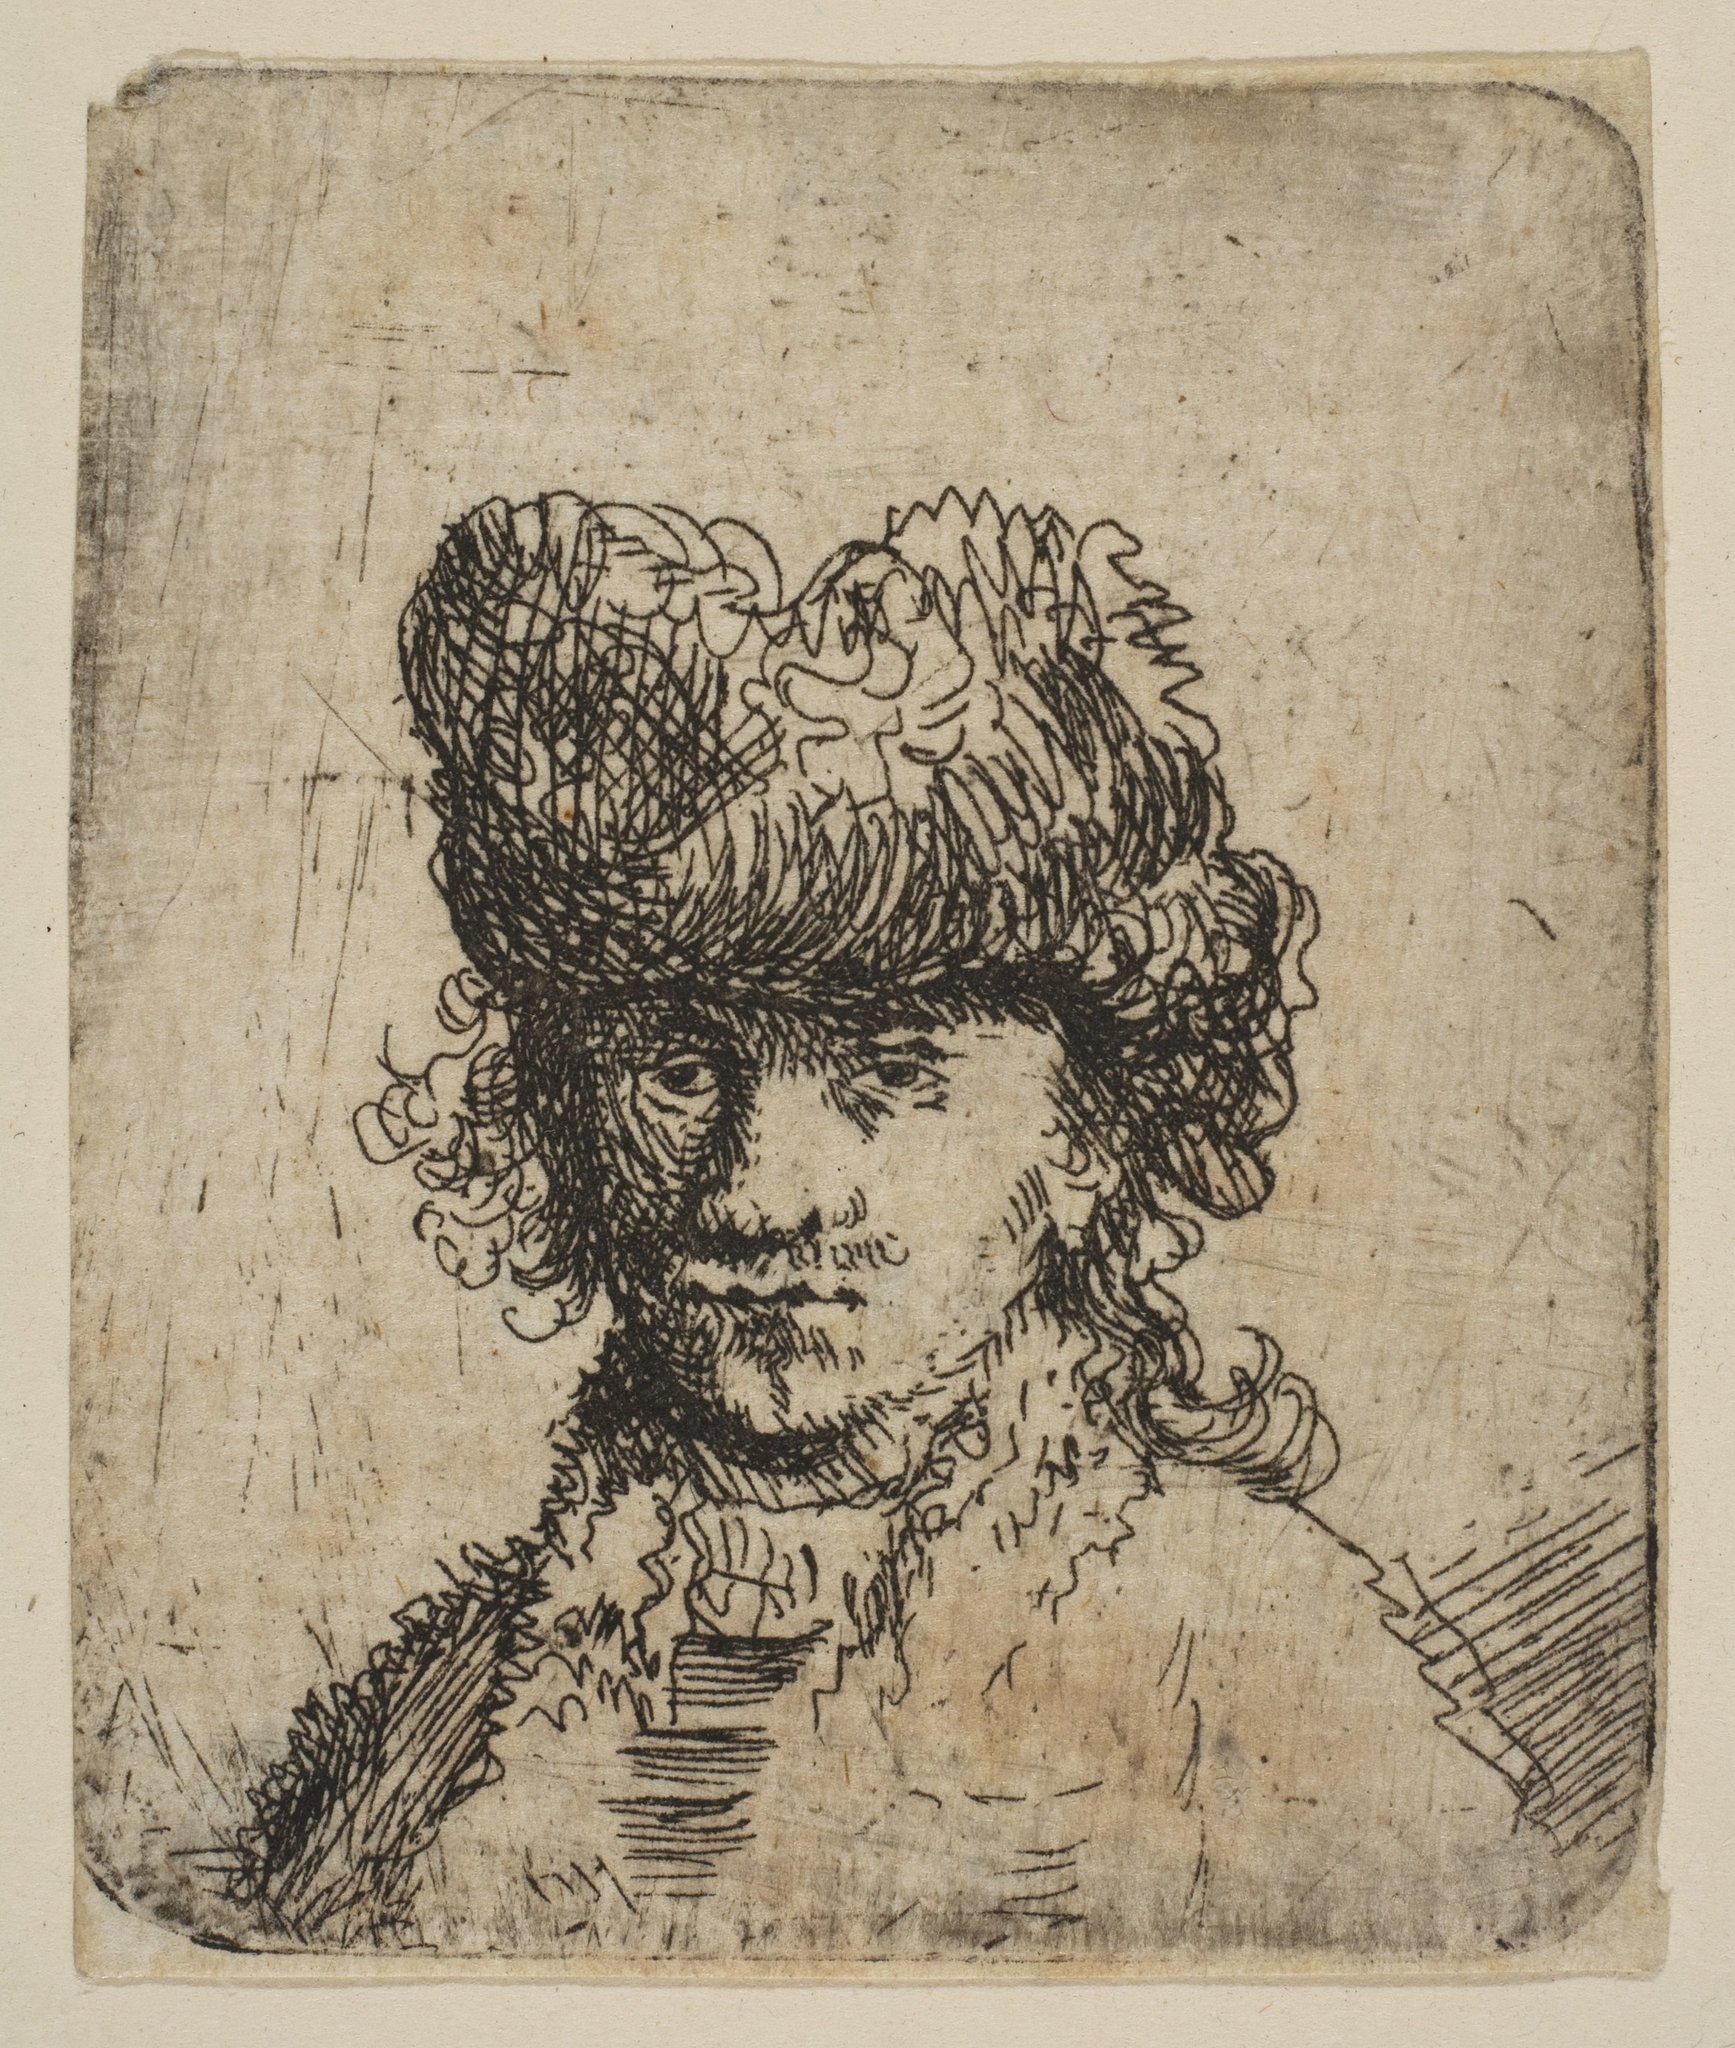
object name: print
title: Self-Portrait in a Fur Cap: Bust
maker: rembrandt van rijn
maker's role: artist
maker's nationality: dutch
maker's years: 1606-1669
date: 1701-1800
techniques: etching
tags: men,self-portraits